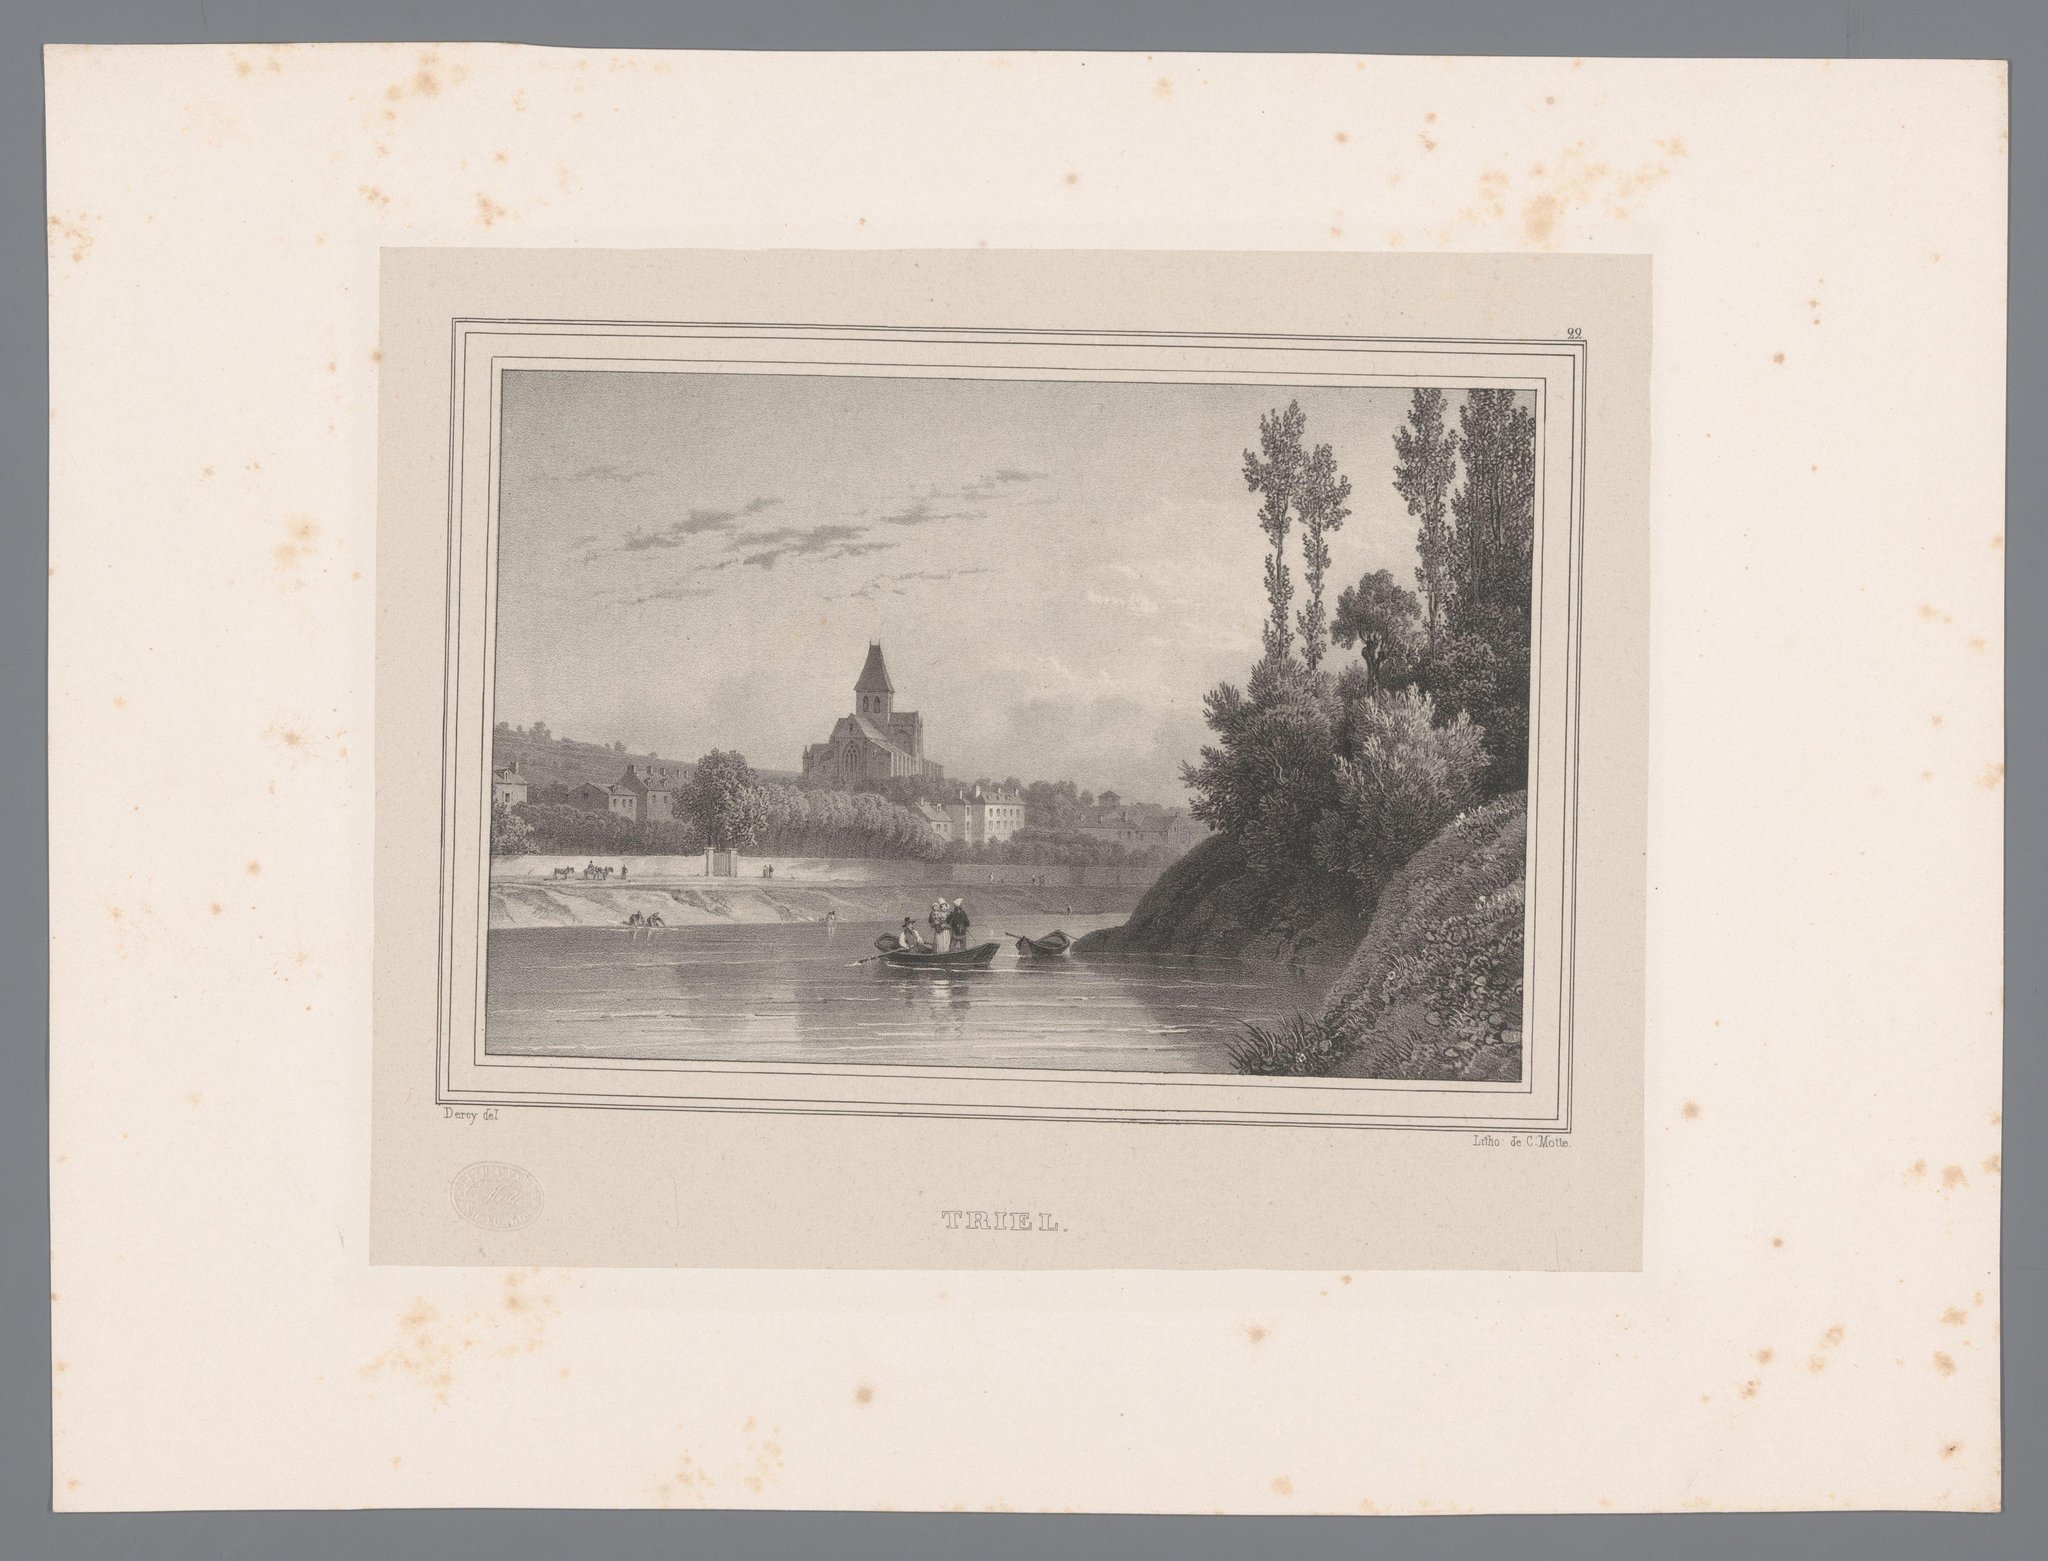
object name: print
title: Zicht op Triel-sur-Seine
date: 1829-1831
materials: paper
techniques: lithograph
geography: paris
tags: rowing-boat, canoe, etc., river (+ landscape with figures, staffage), prospect of city, town panorama, silhouette of city (+ city(-scape) with figures, staffage)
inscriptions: collector's mark: Lugt 2228a, check stamp: Lugt 1828b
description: Prent maakt deel uit van een omslag met twaalf prenten.